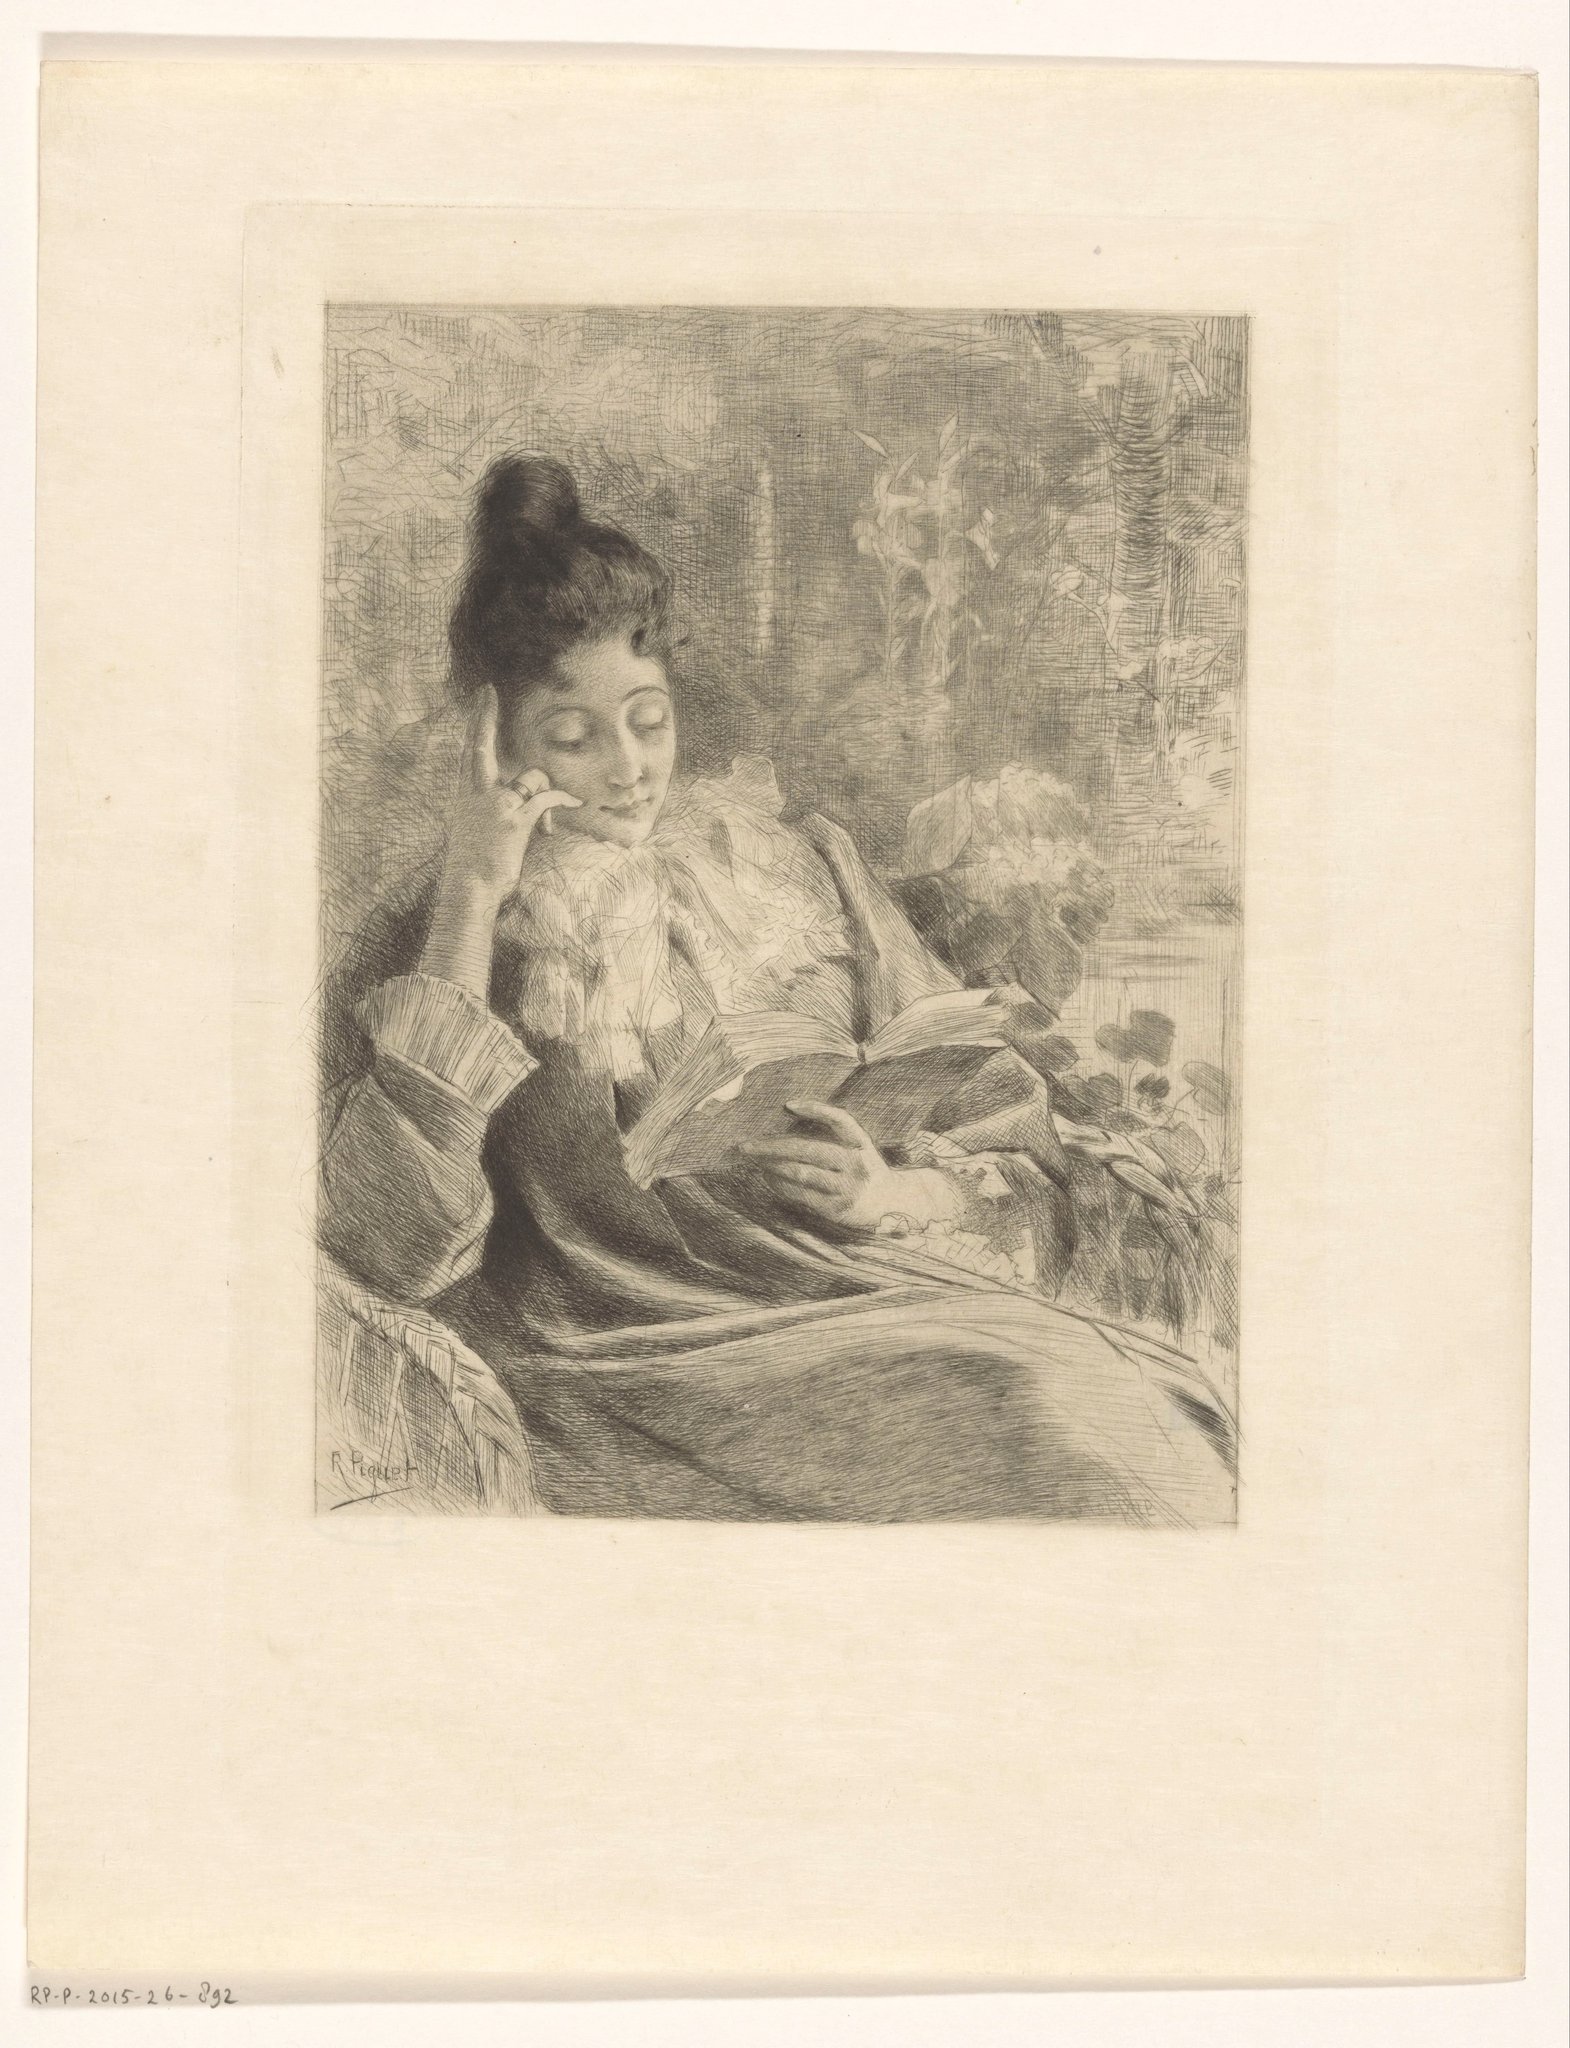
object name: print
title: Lezende vrouw in een stoel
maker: rodolphe piguet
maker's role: draughtsman, painter, print maker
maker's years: 1840-1915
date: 1850-1915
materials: paper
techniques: drypoint, intaglio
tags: book, newspaper, news-sheet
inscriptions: collector's mark: Lugt 4780, collector's mark: Lugt 2228